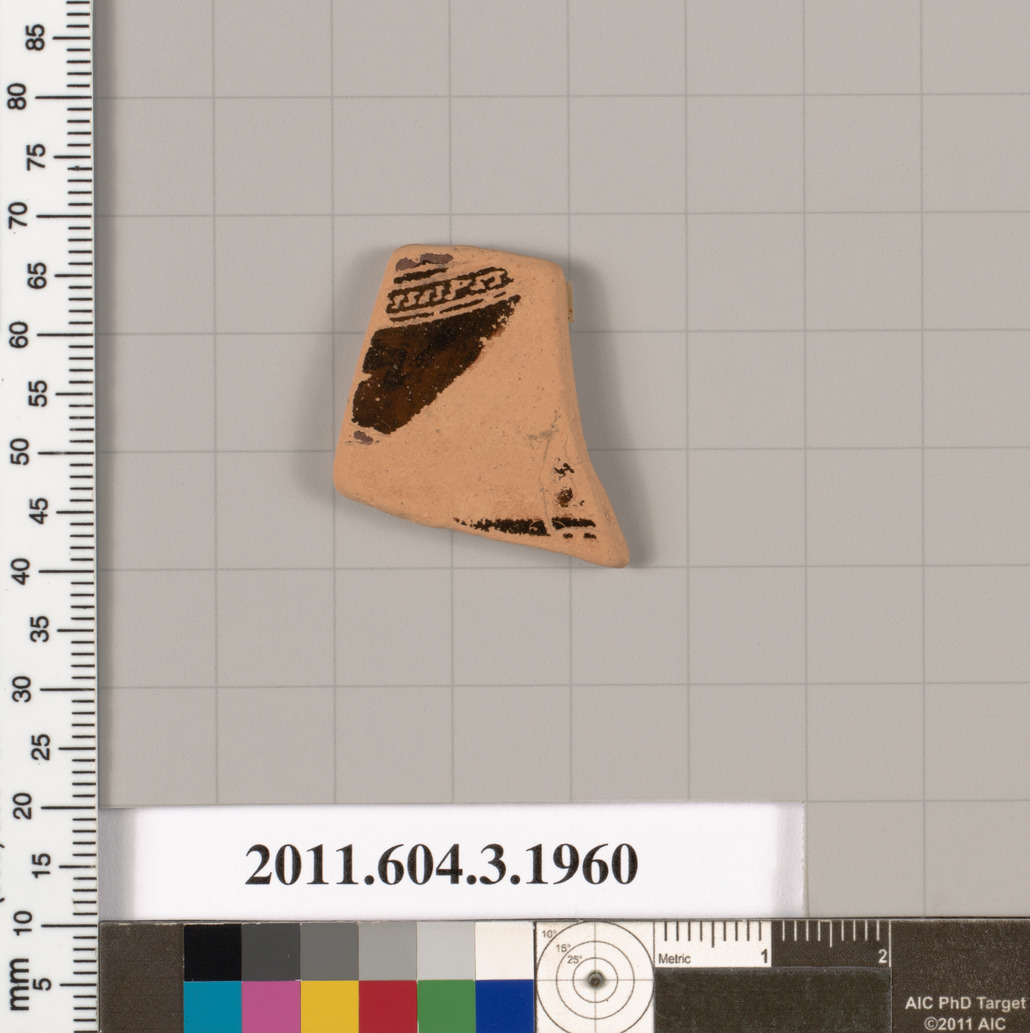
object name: kylix fragment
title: Terracotta fragment of a kylix (drinking cup)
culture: greek, attic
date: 550-526 BCE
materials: terracotta